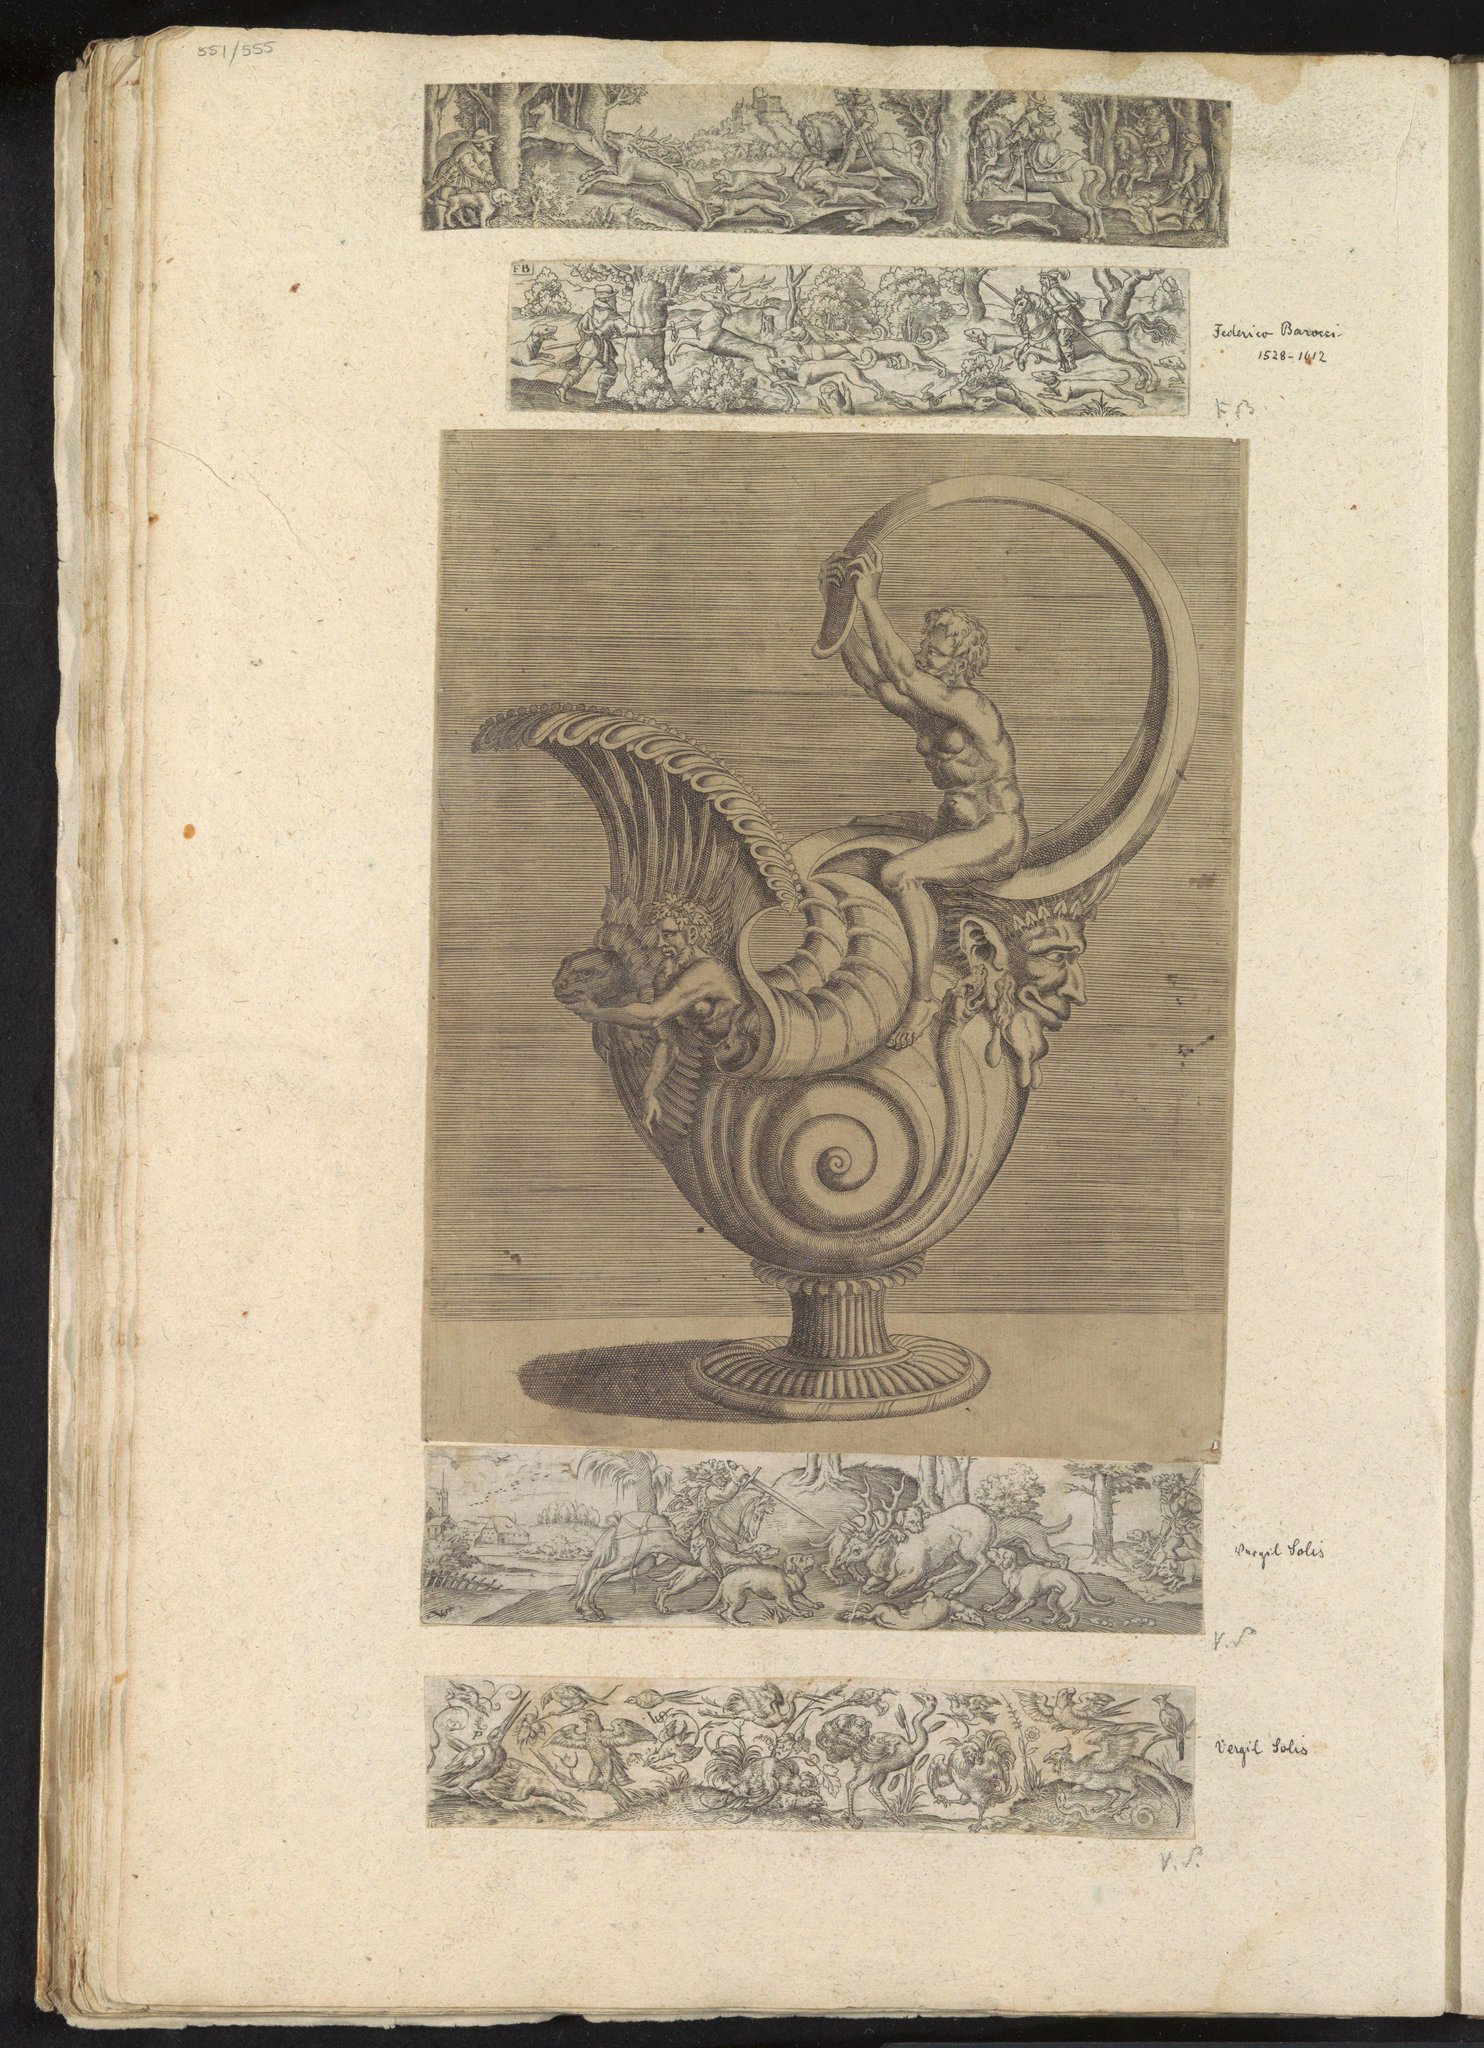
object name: ornament print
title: Albumblad met vijf prenten met een kan, jachtscènes en vogels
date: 1500-1599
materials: paper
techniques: engraving, etching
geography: antwerp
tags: kitchen-utensils: cauldron, walker and runner birds: ostrich, stag-hunting, birds, ornamental birds: parrot, hunters hunting (n.b.: in 1988-1990 this notation denoted the concept of 43c11421 'hunters resting during the hunt'), hunt ~ mammals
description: Albumblad met vijf uitgeknipte prenten: drie jachtscènes, een ornamentele kan en een fries met vogels.